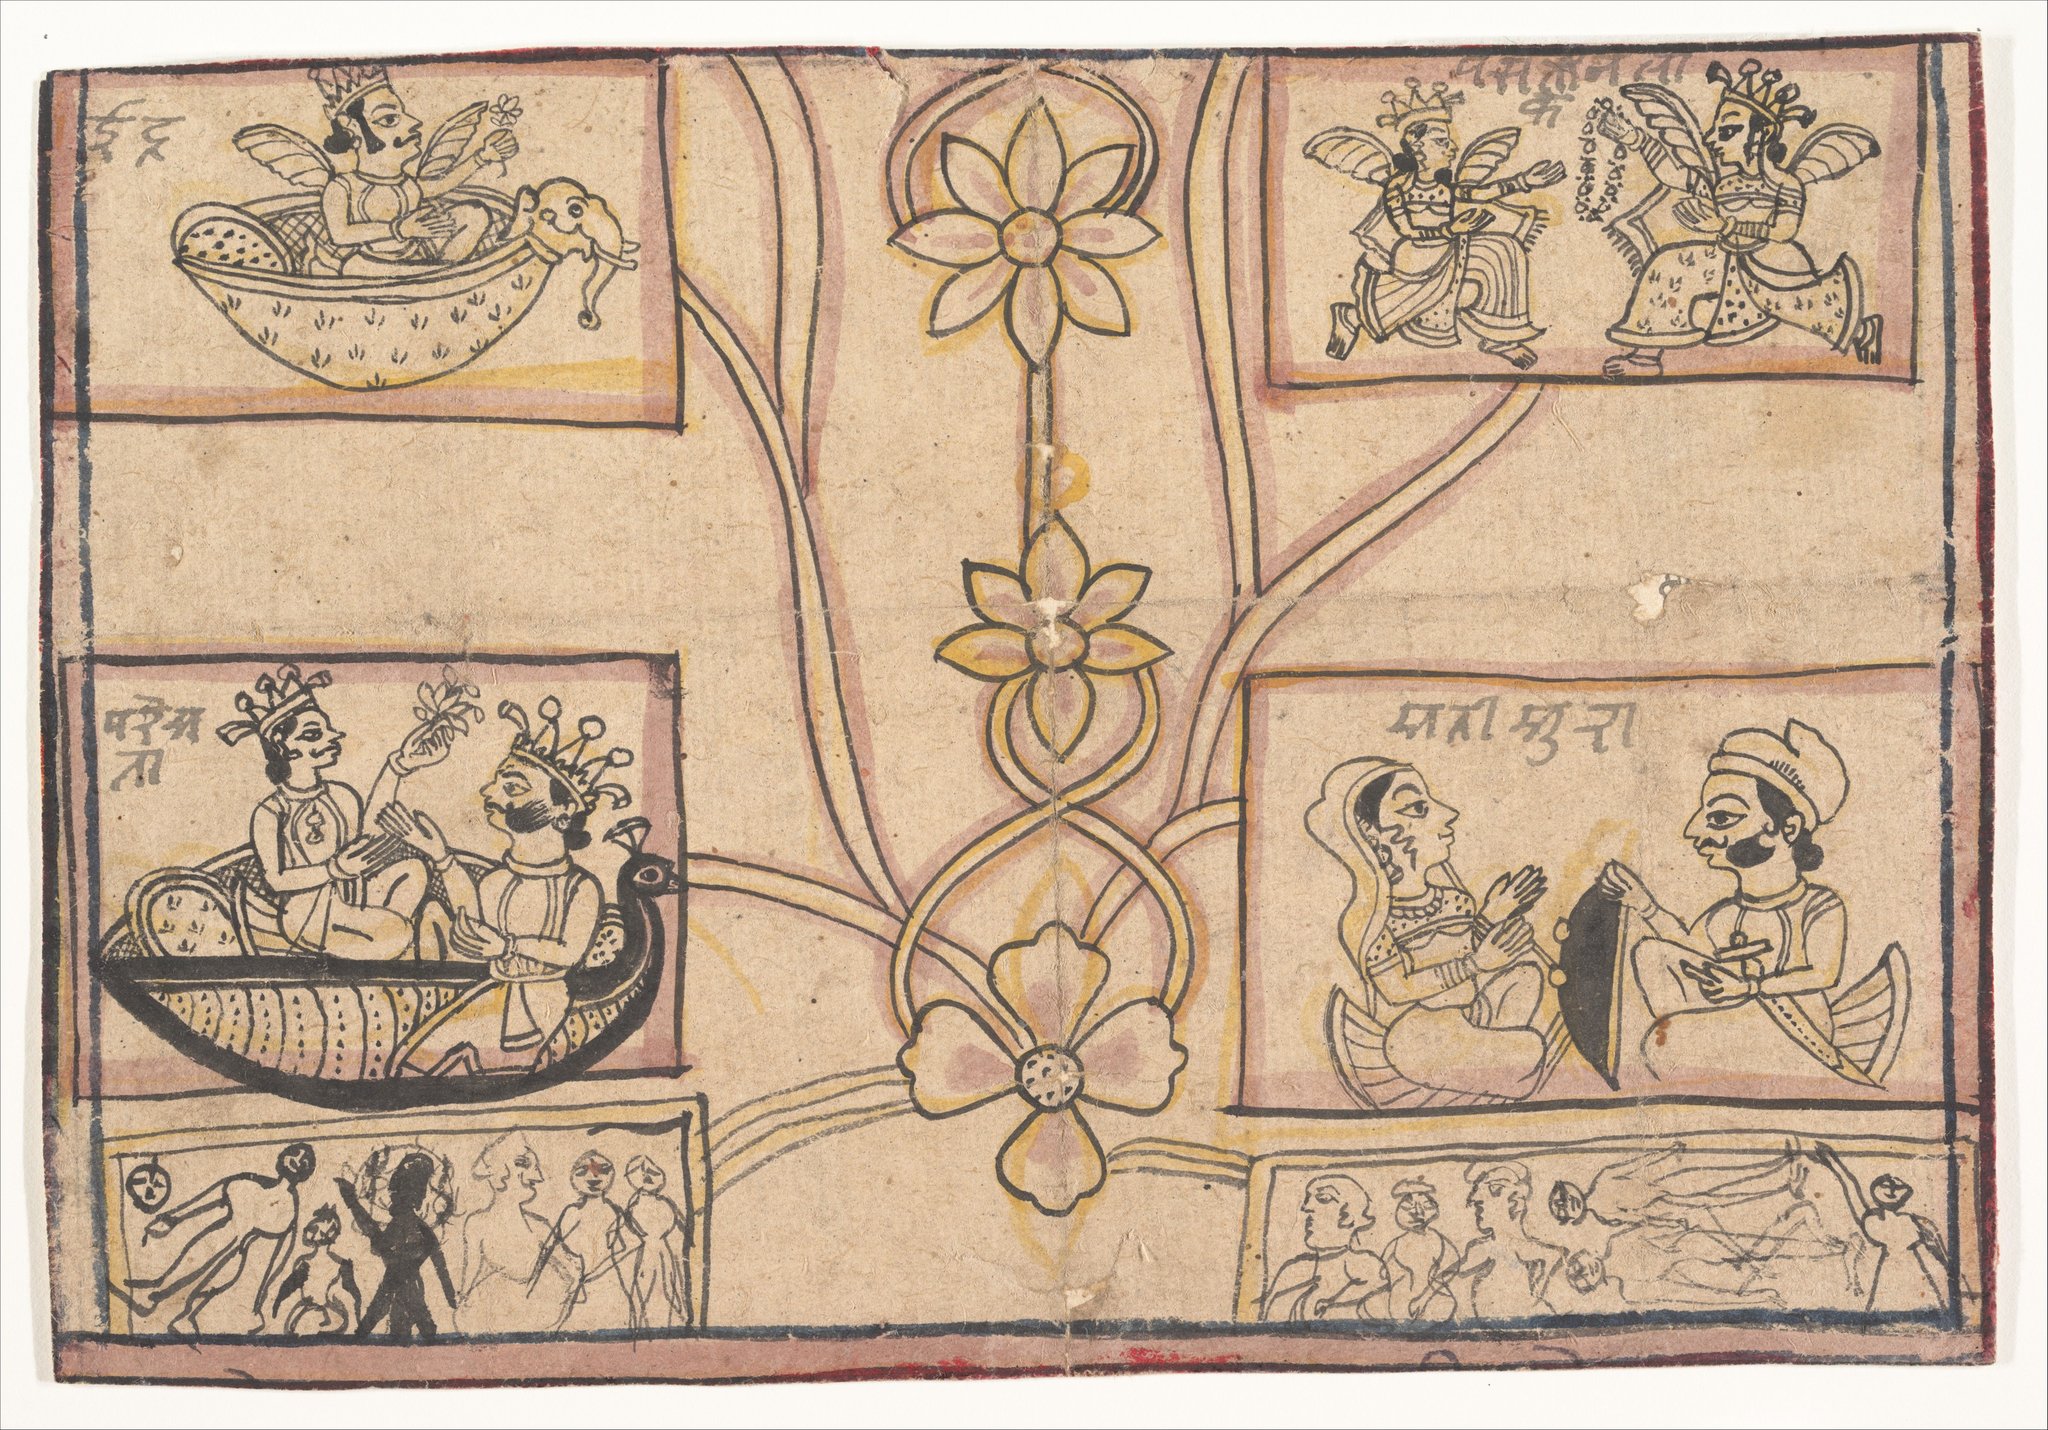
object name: painting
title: Horoscope with Floral Drawings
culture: indian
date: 1850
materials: ink, paper, watercolor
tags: men,women,flowers,astrology